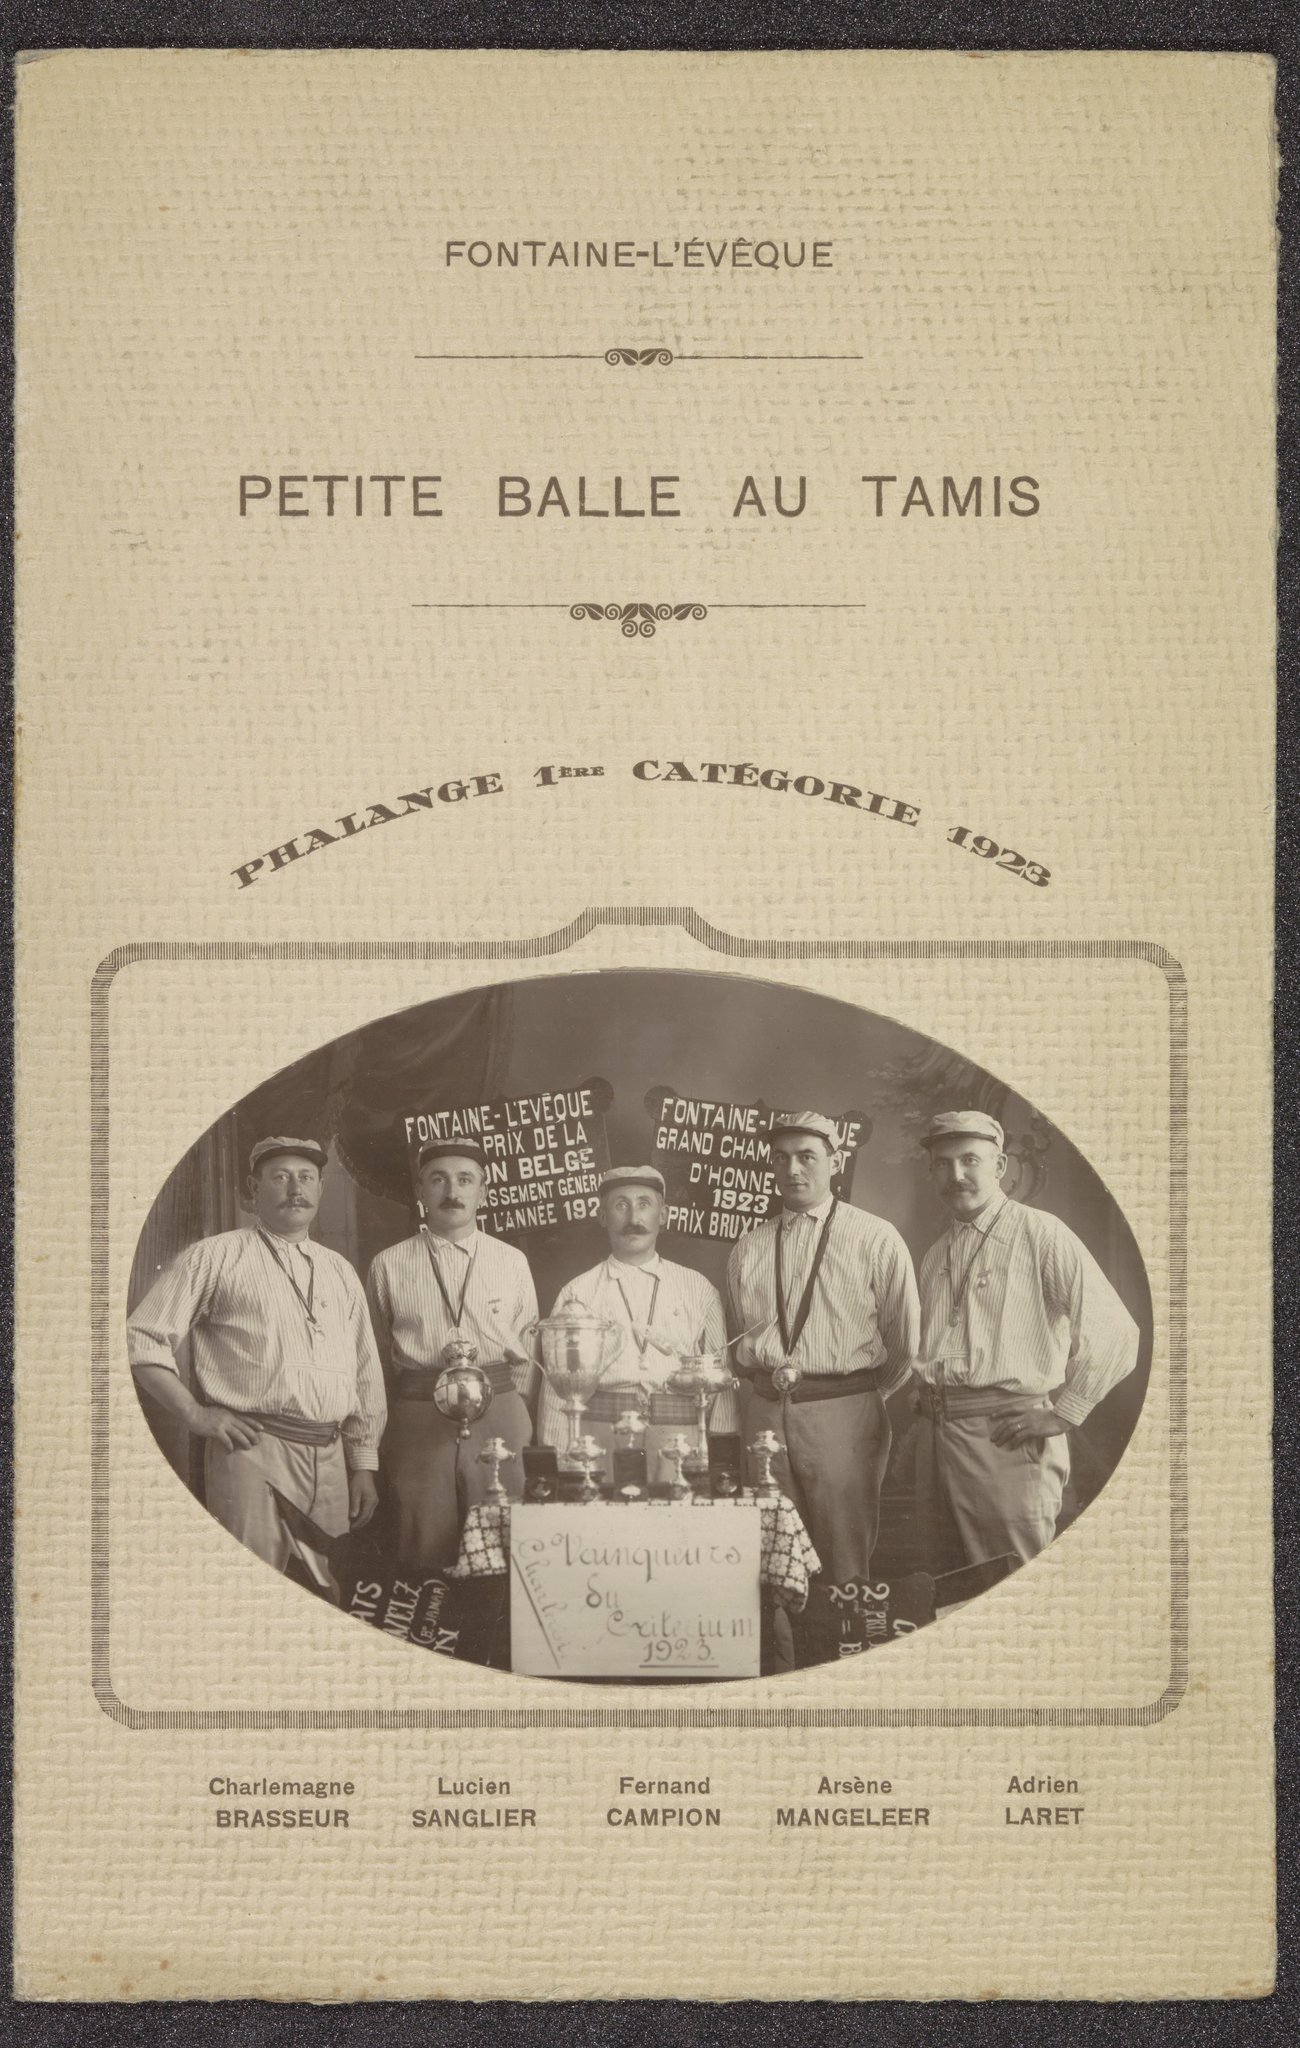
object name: photograph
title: Groepsportret van vijf sporters met trofeeën, voorop een menukaart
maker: Anonymous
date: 1923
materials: paper, cardboard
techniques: letterpress printing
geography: charleroi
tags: trophy, i.e.: decorative arrangement of symbolic or typical objects ~ ornament, adult man, historical persons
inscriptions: inscription: ‘Saison ballante/ 1923 (...) Menu (...)’